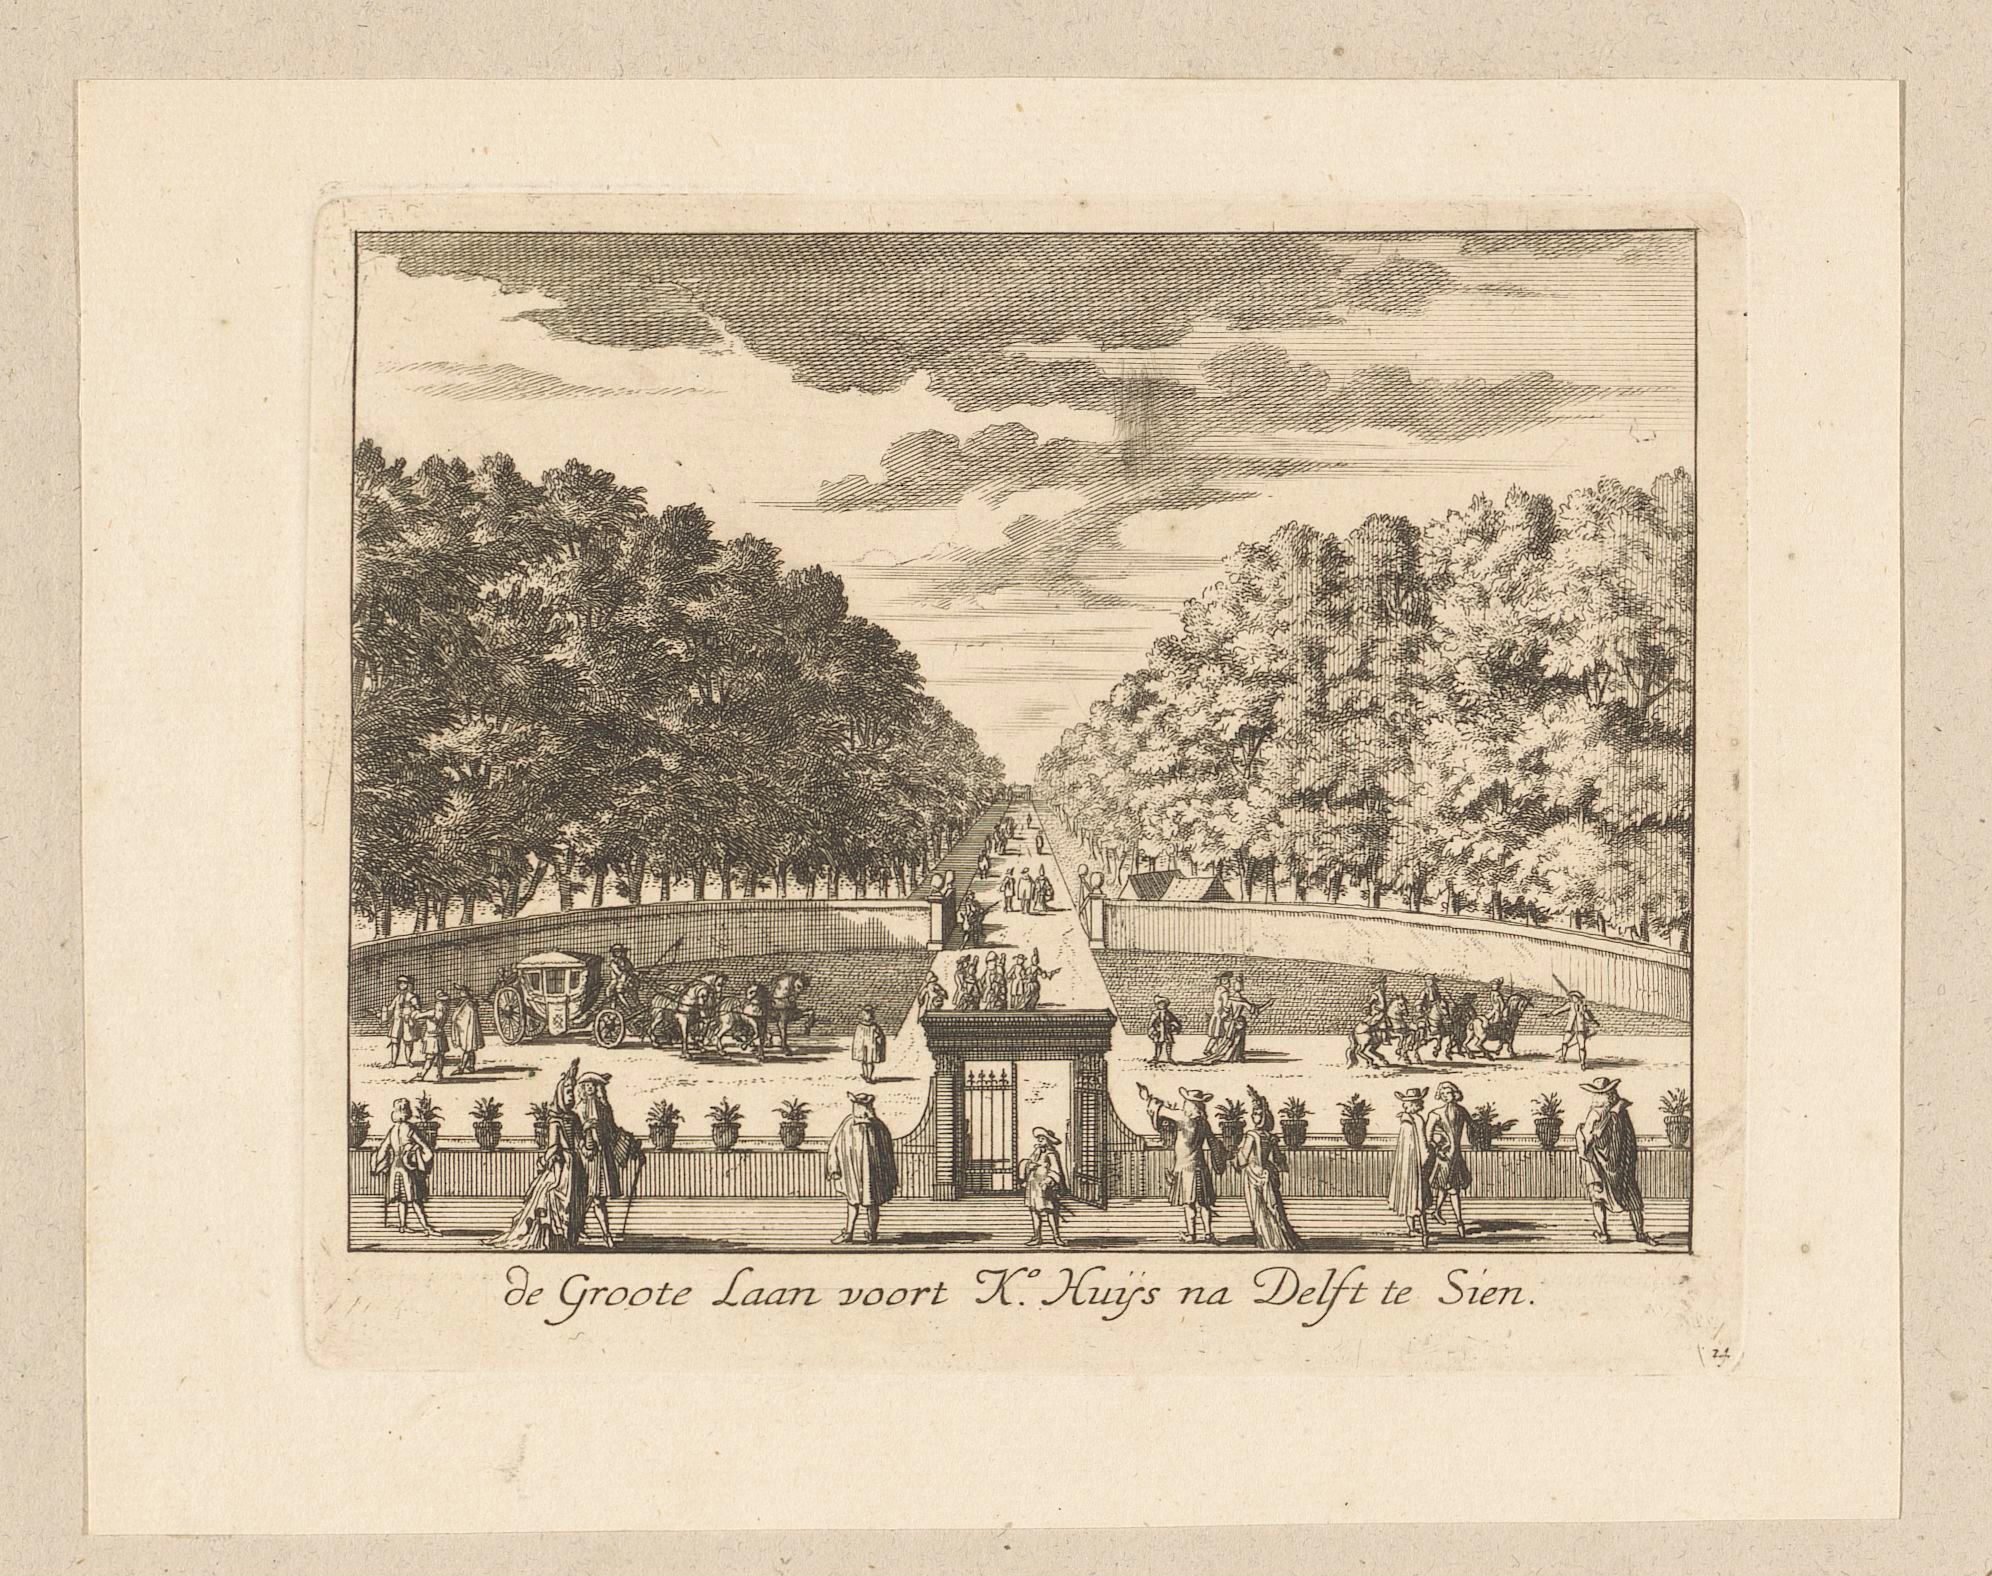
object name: print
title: Zestien prenten van Paleis Honselaarsdijk (Danckerts / Covens en Mortier)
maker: cornelis danckerts (ii)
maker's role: print maker, publisher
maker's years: 1664-1717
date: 1696-1717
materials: paper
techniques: etching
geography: amsterdam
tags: palace, road, path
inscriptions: collector's mark: Lugt 2233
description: Plein met wandelaars, in het midden de laan voor Paleis Honselaarsdijk richting Delft. Op de laan rijtuigen en ruiters, aan weerszijden bomen. Rechtsonder genummerd: 14. Prent uit een serie van zestien prenten van Paleis Honselaarsdijk.